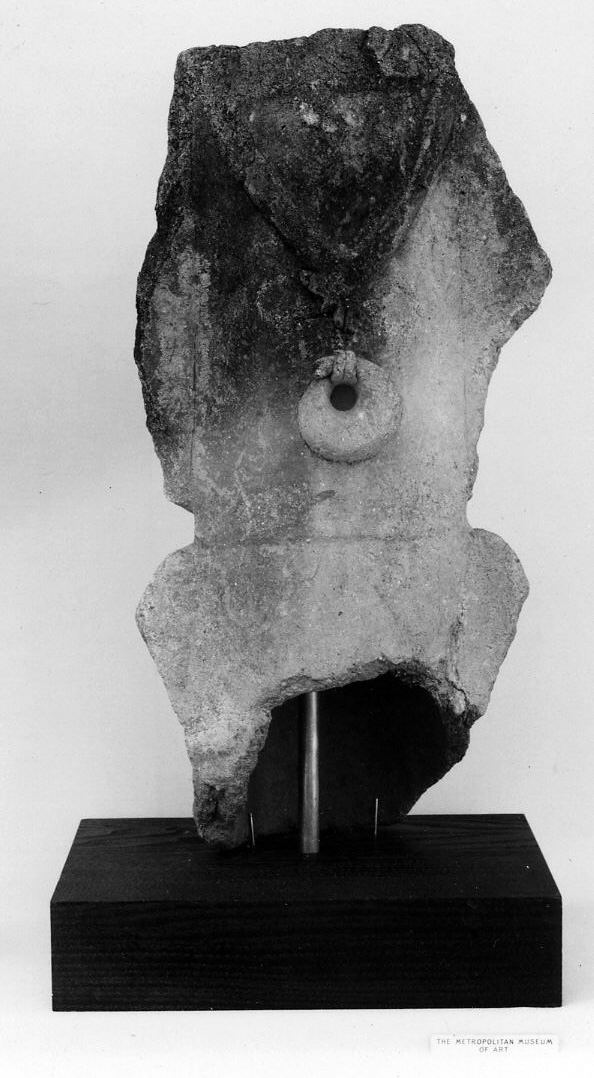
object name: haniwa fragment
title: Fragment of Haniwa Statuette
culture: japanese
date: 601-700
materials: earthenware